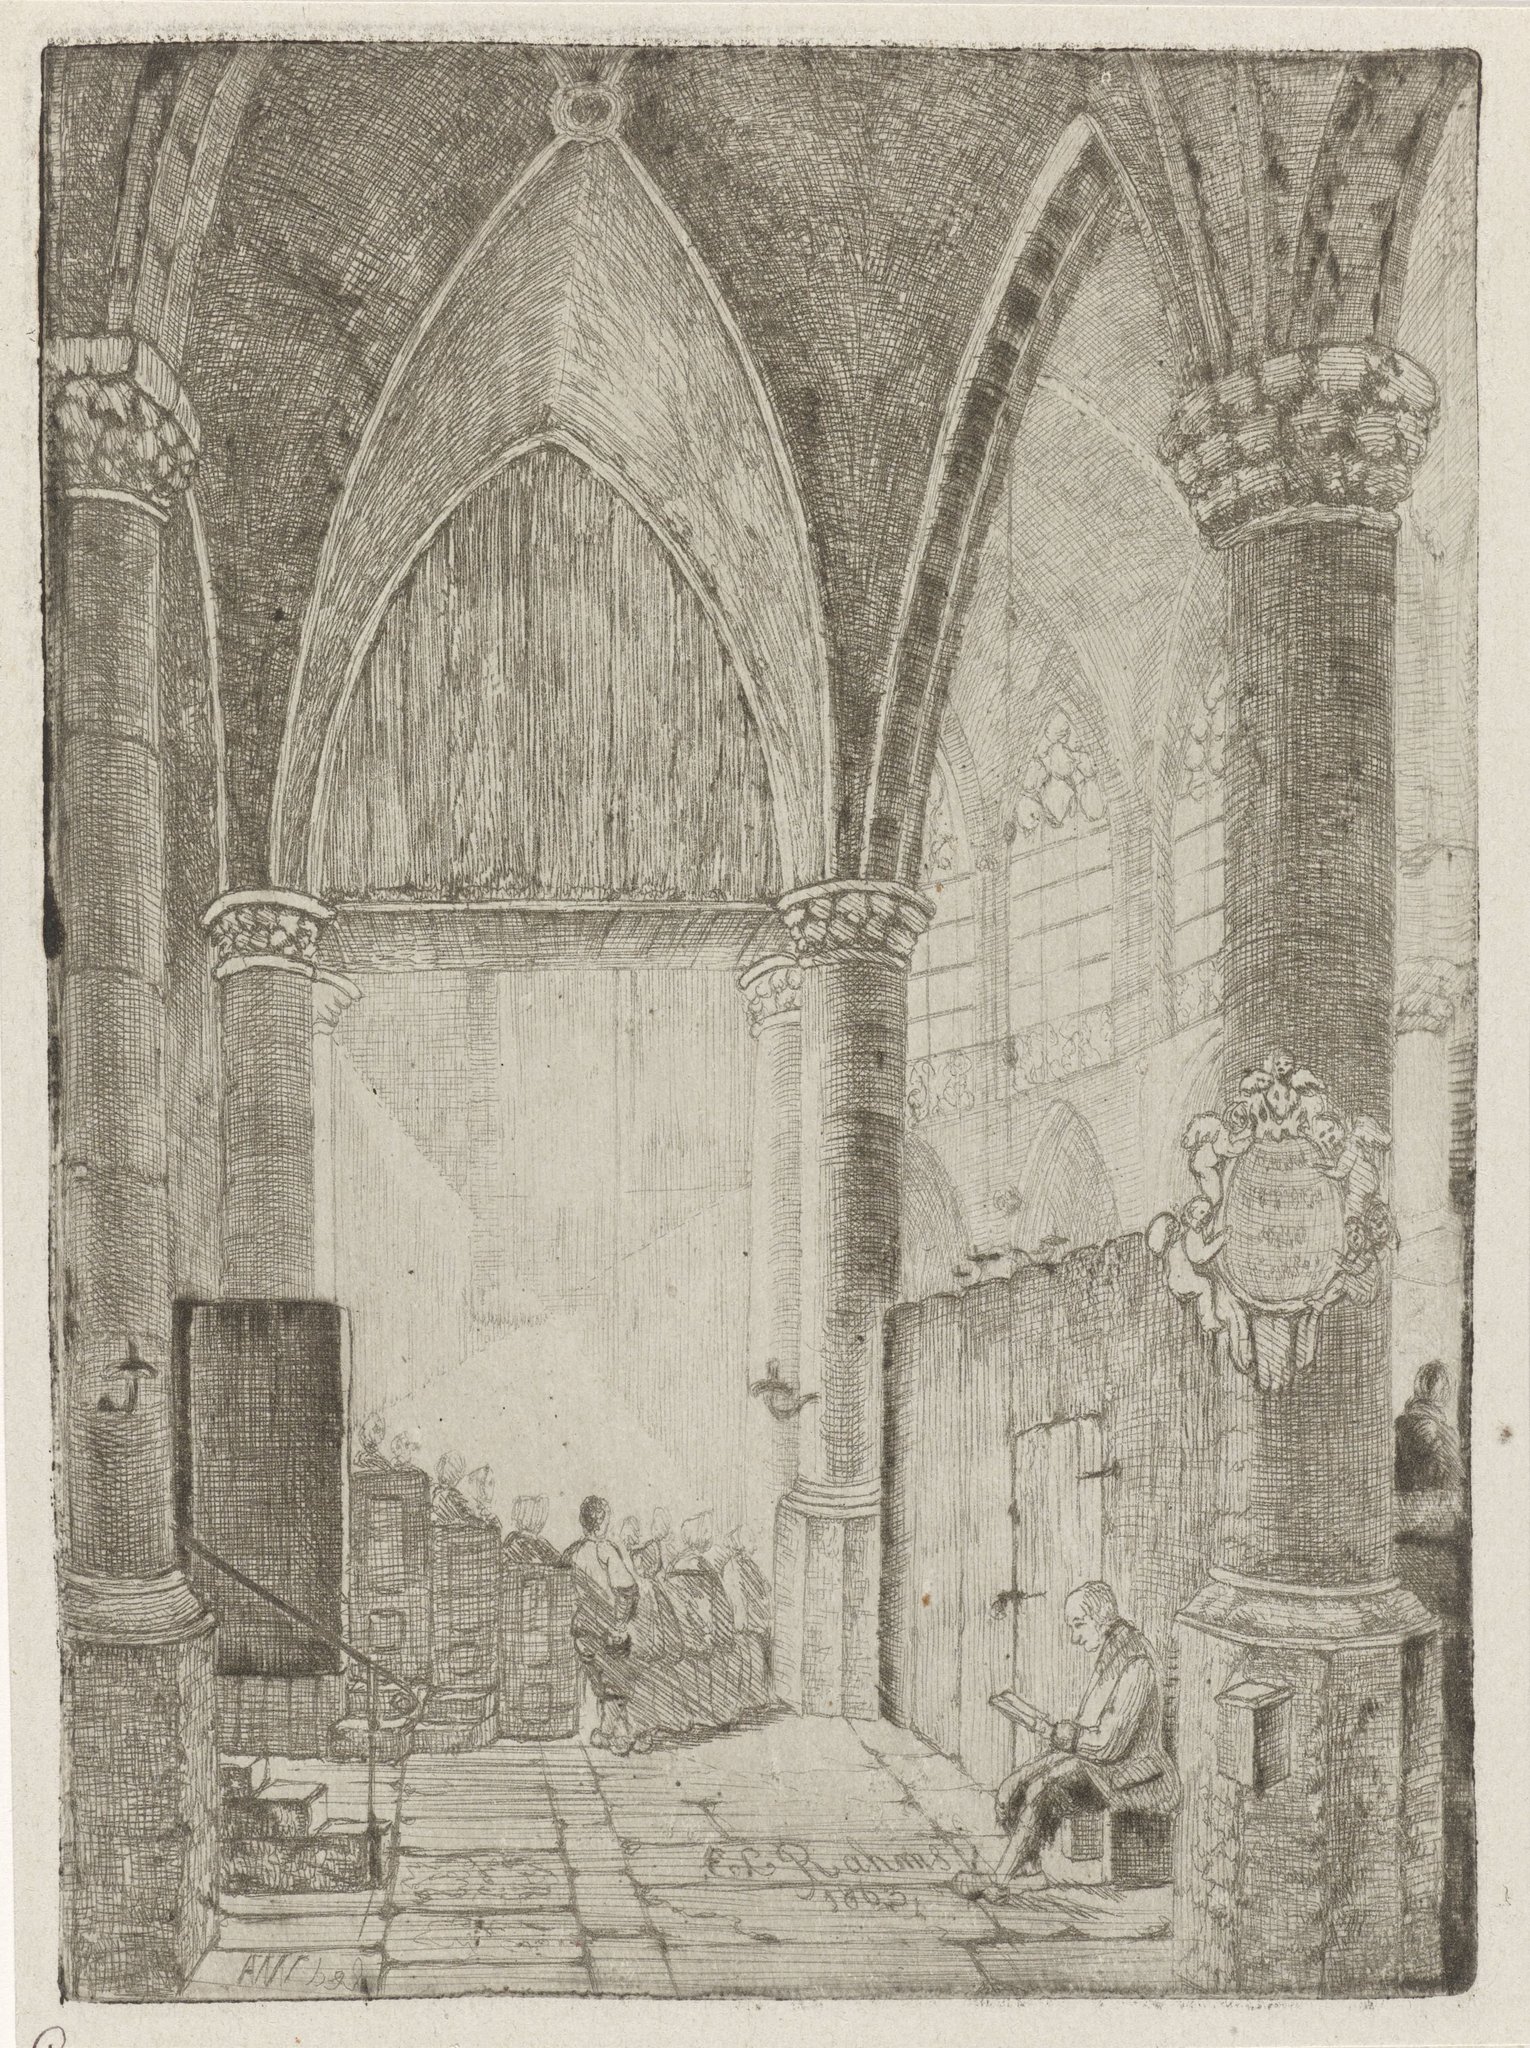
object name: print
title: Kerkdienst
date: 1863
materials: paper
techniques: etching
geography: oudewater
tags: interior of church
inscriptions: collector's mark: Lugt 2228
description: Gezicht op een kerkinterieur waar een kerkdienst wordt gehouden. Op de voorgrond zit een man te lezen.